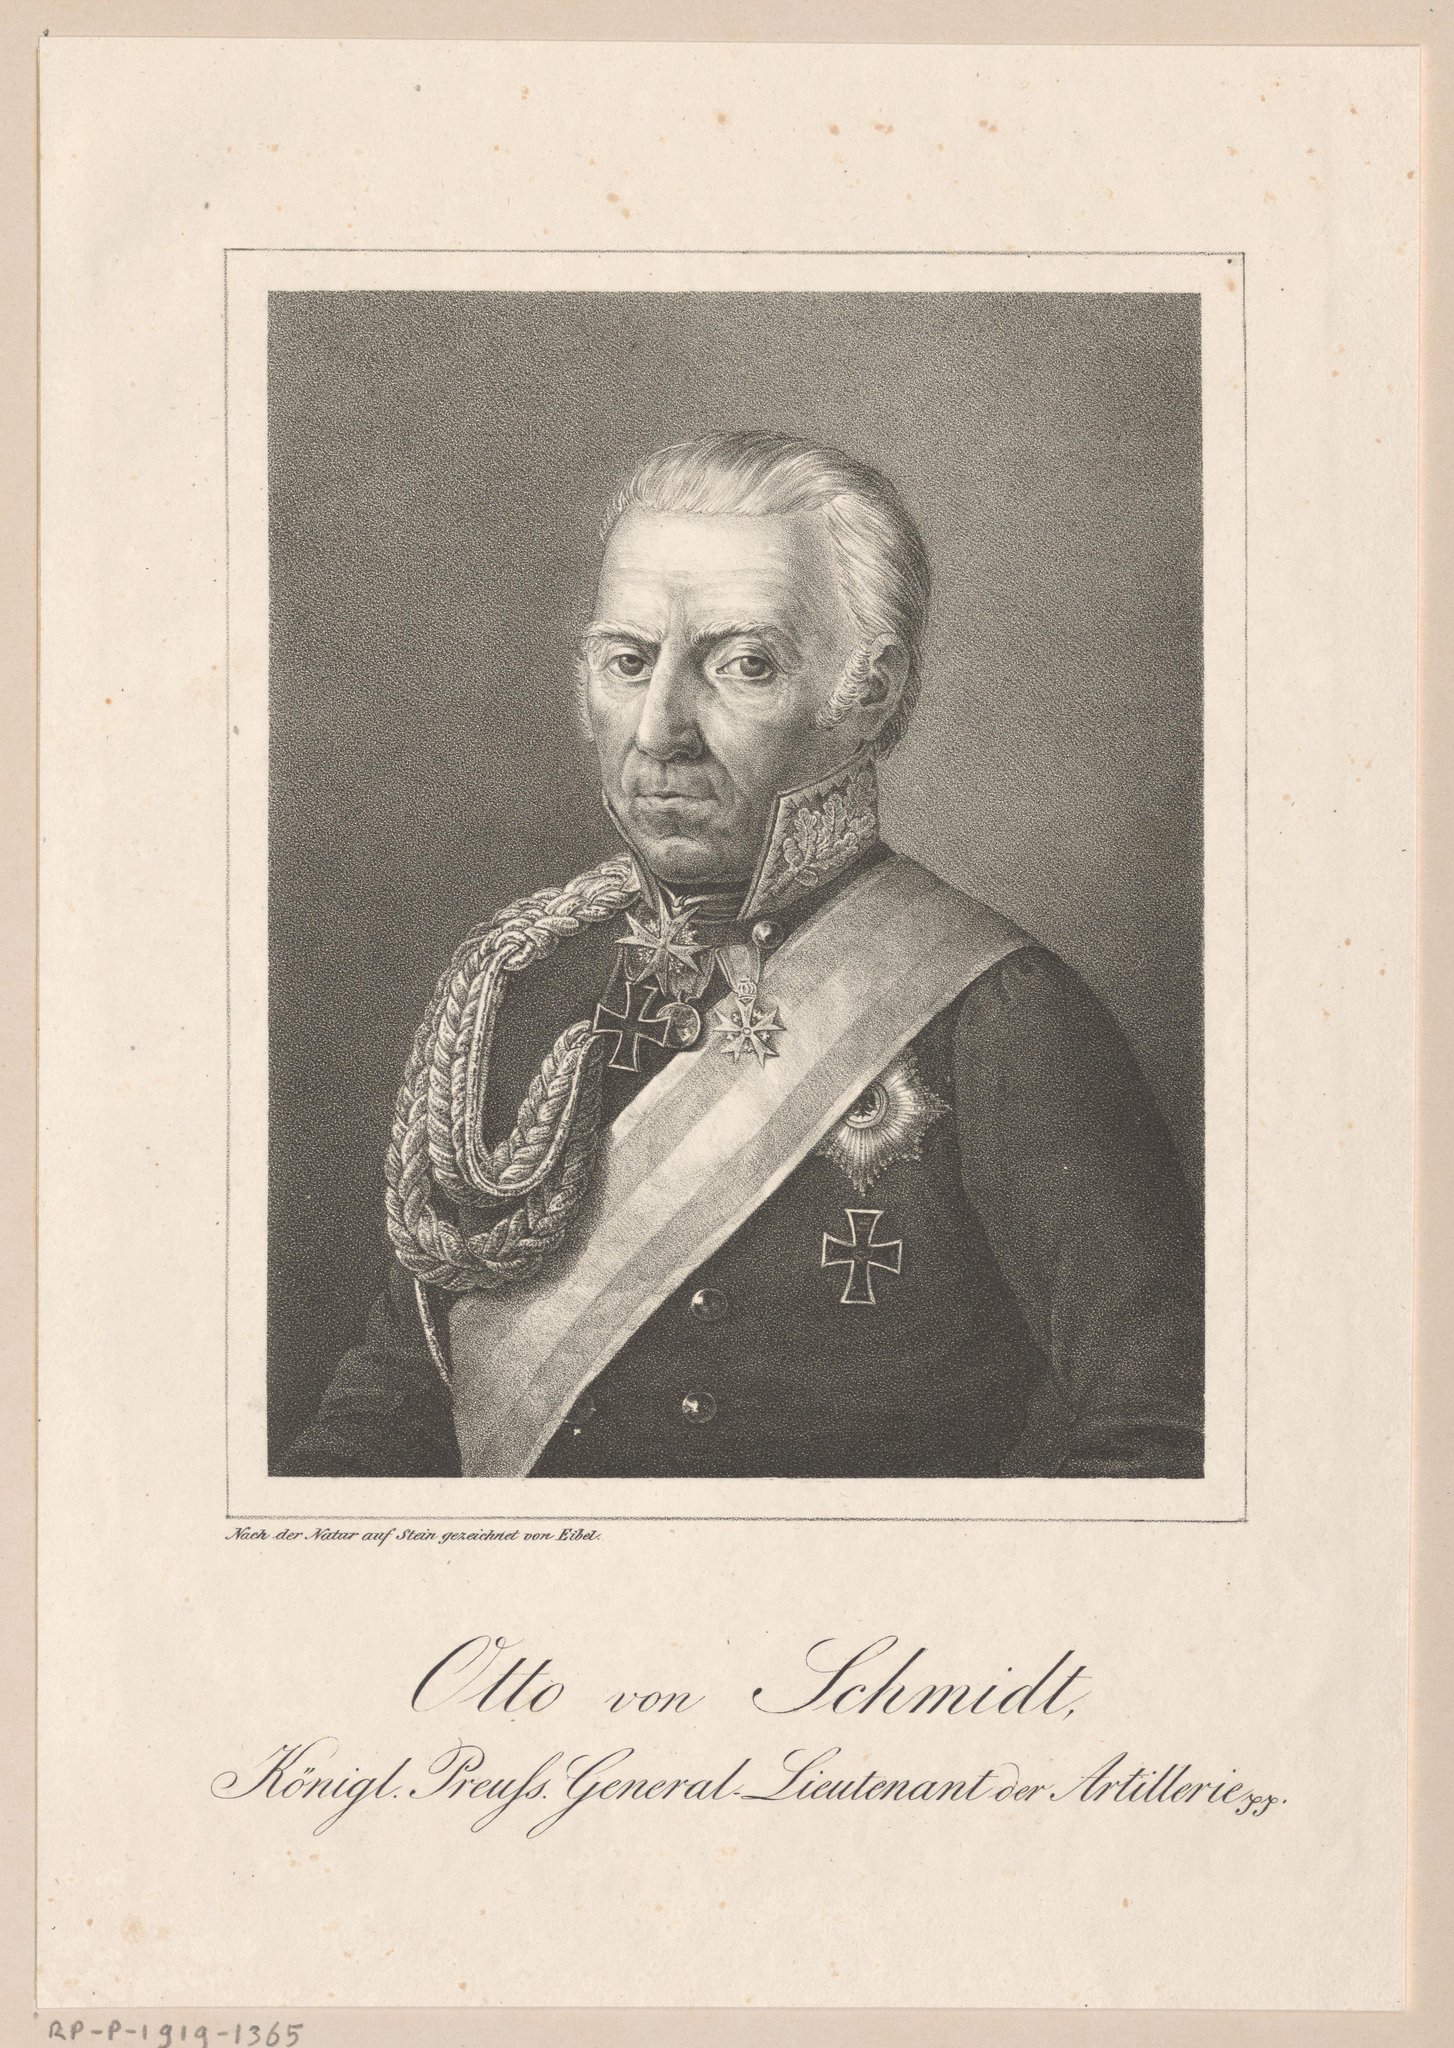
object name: print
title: Portret van Johann Heinrich Otto von Schmidt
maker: eibel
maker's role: print maker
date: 1820-1880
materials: paper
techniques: lithograph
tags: commander-in-chief, general, marshal, historical persons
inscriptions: collector's mark: Lugt 2228